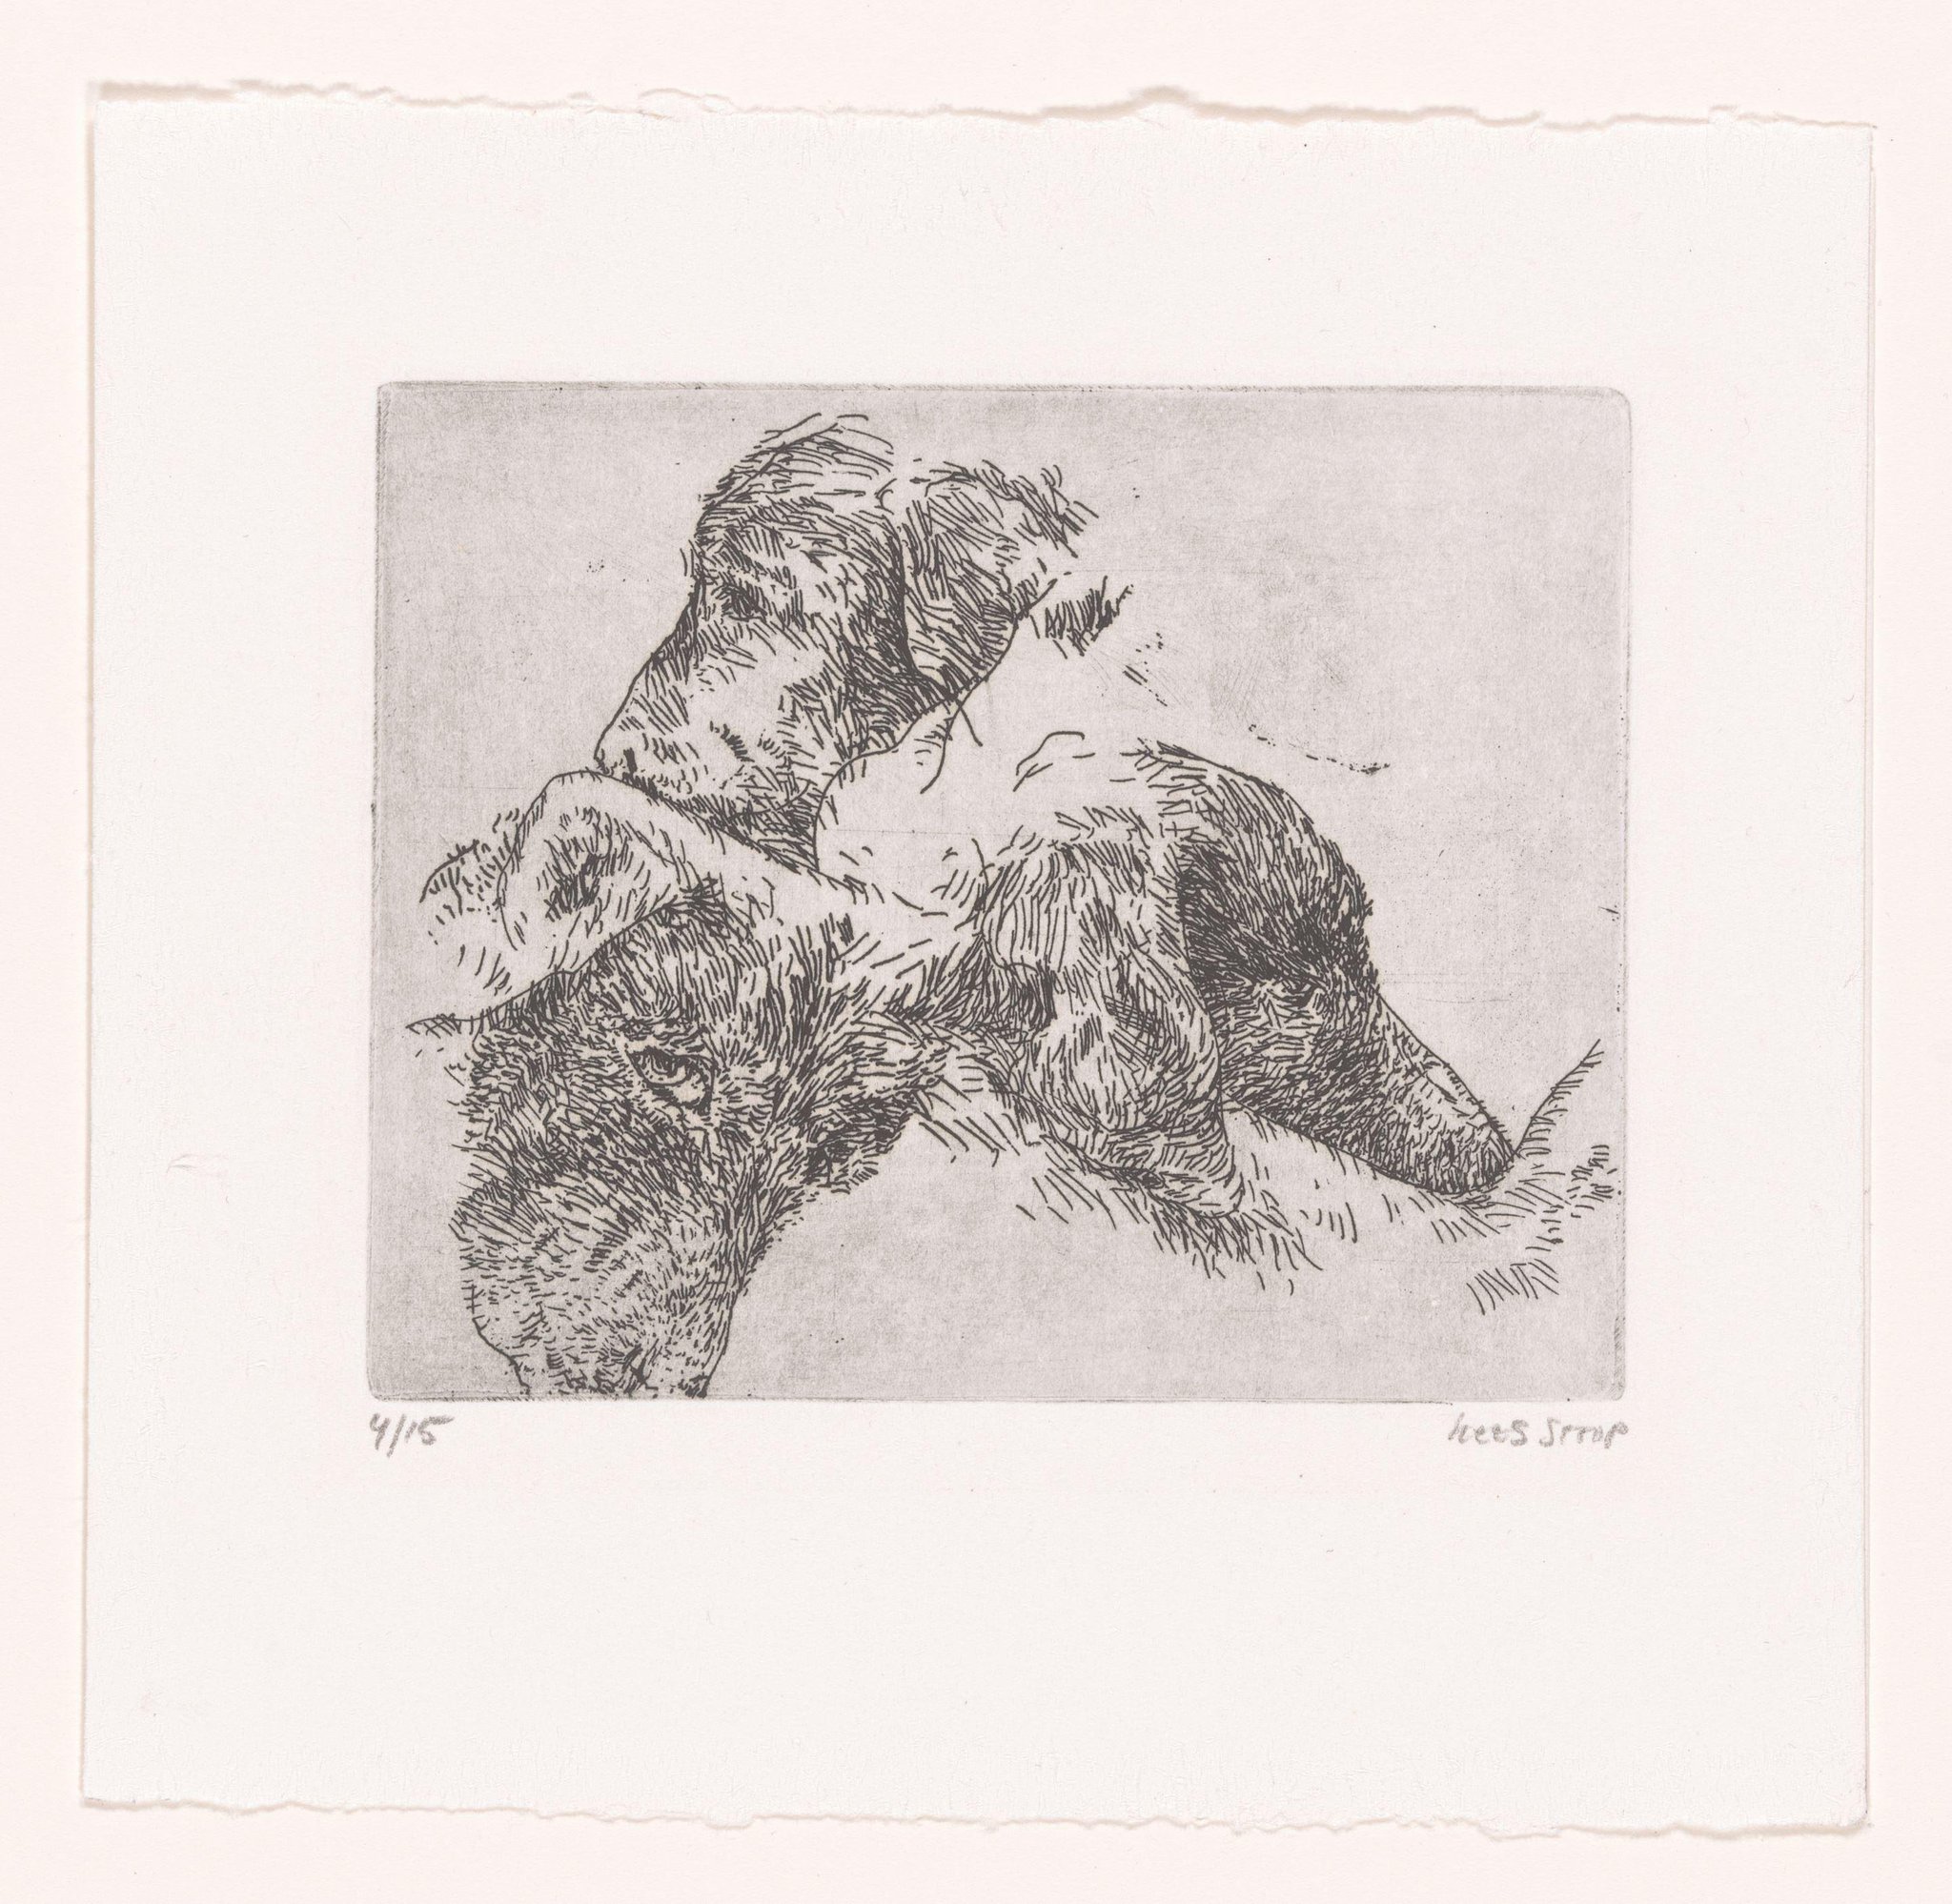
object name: print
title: Hondenkoppen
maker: kees stoop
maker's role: draughtsman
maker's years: 1929-2019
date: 1944-1990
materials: paper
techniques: etching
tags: dog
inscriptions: edition: ‘4/15’, signature: ‘kees Stoop’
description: Fragmenten van hondenkoppen, in elkaar overlopend.